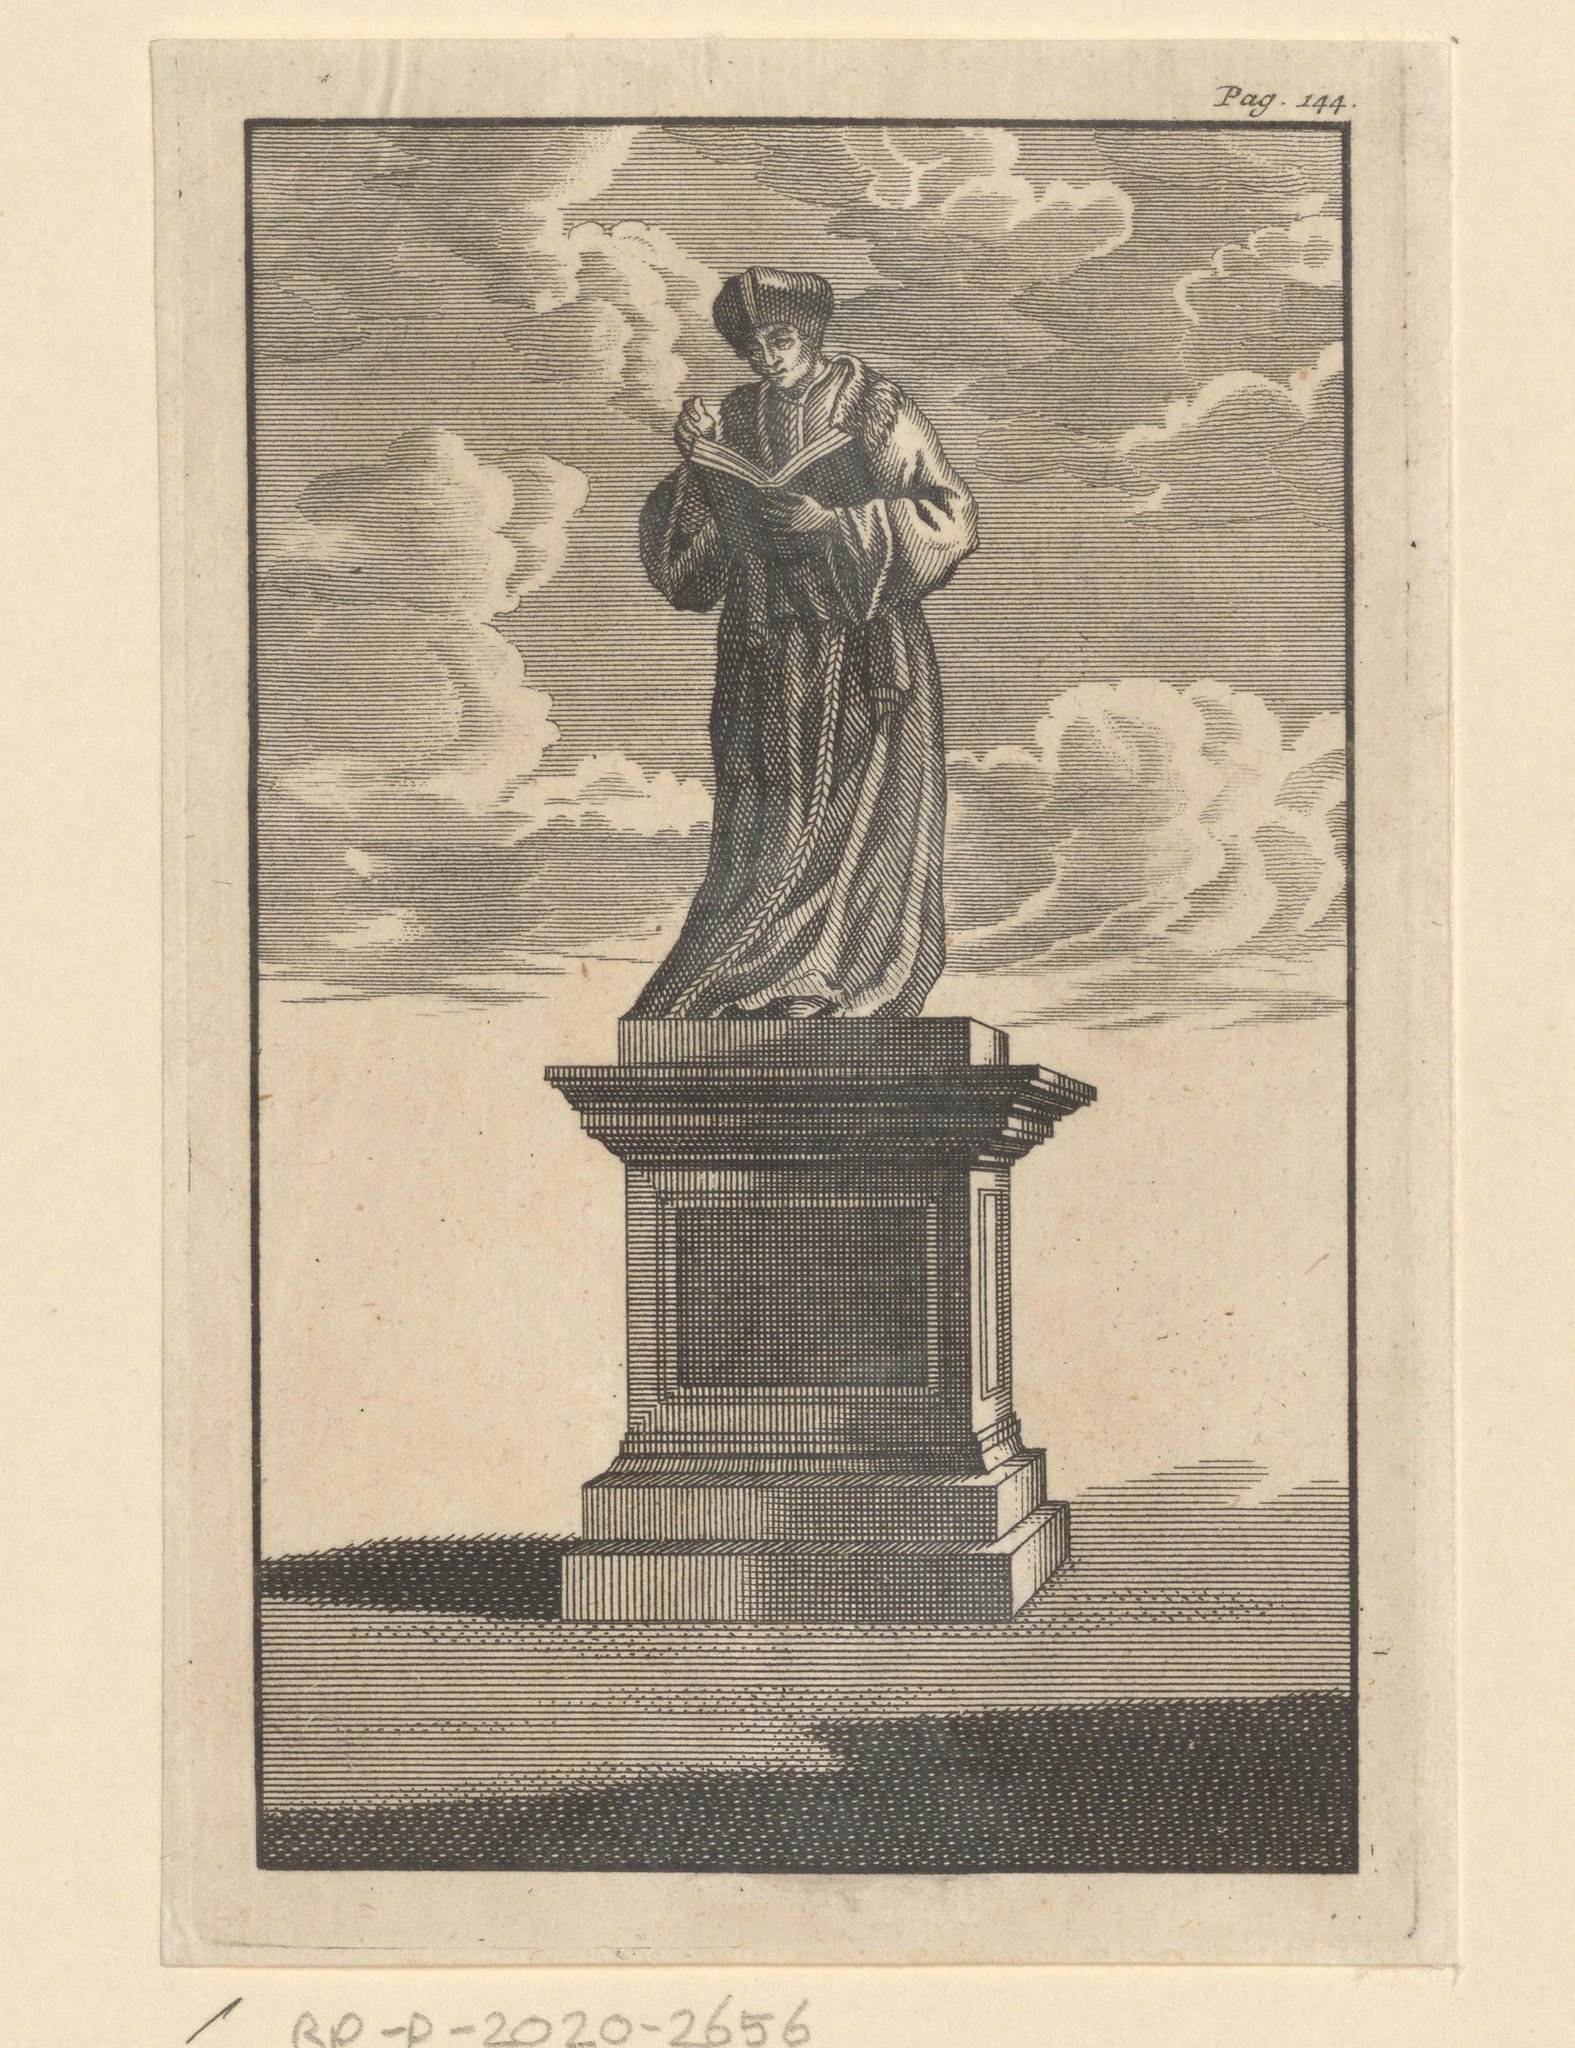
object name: print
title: Standbeeld van Desiderius Erasmus te Rotterdam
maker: Anonymous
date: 1650-1750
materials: paper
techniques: etching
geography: netherlands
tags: rotterdam, desiderius erasmus, historical persons, monument, statue, scholar, philosopher (+ portrait of scholar, scientist)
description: Prent komt uit een onbekende publicatie.